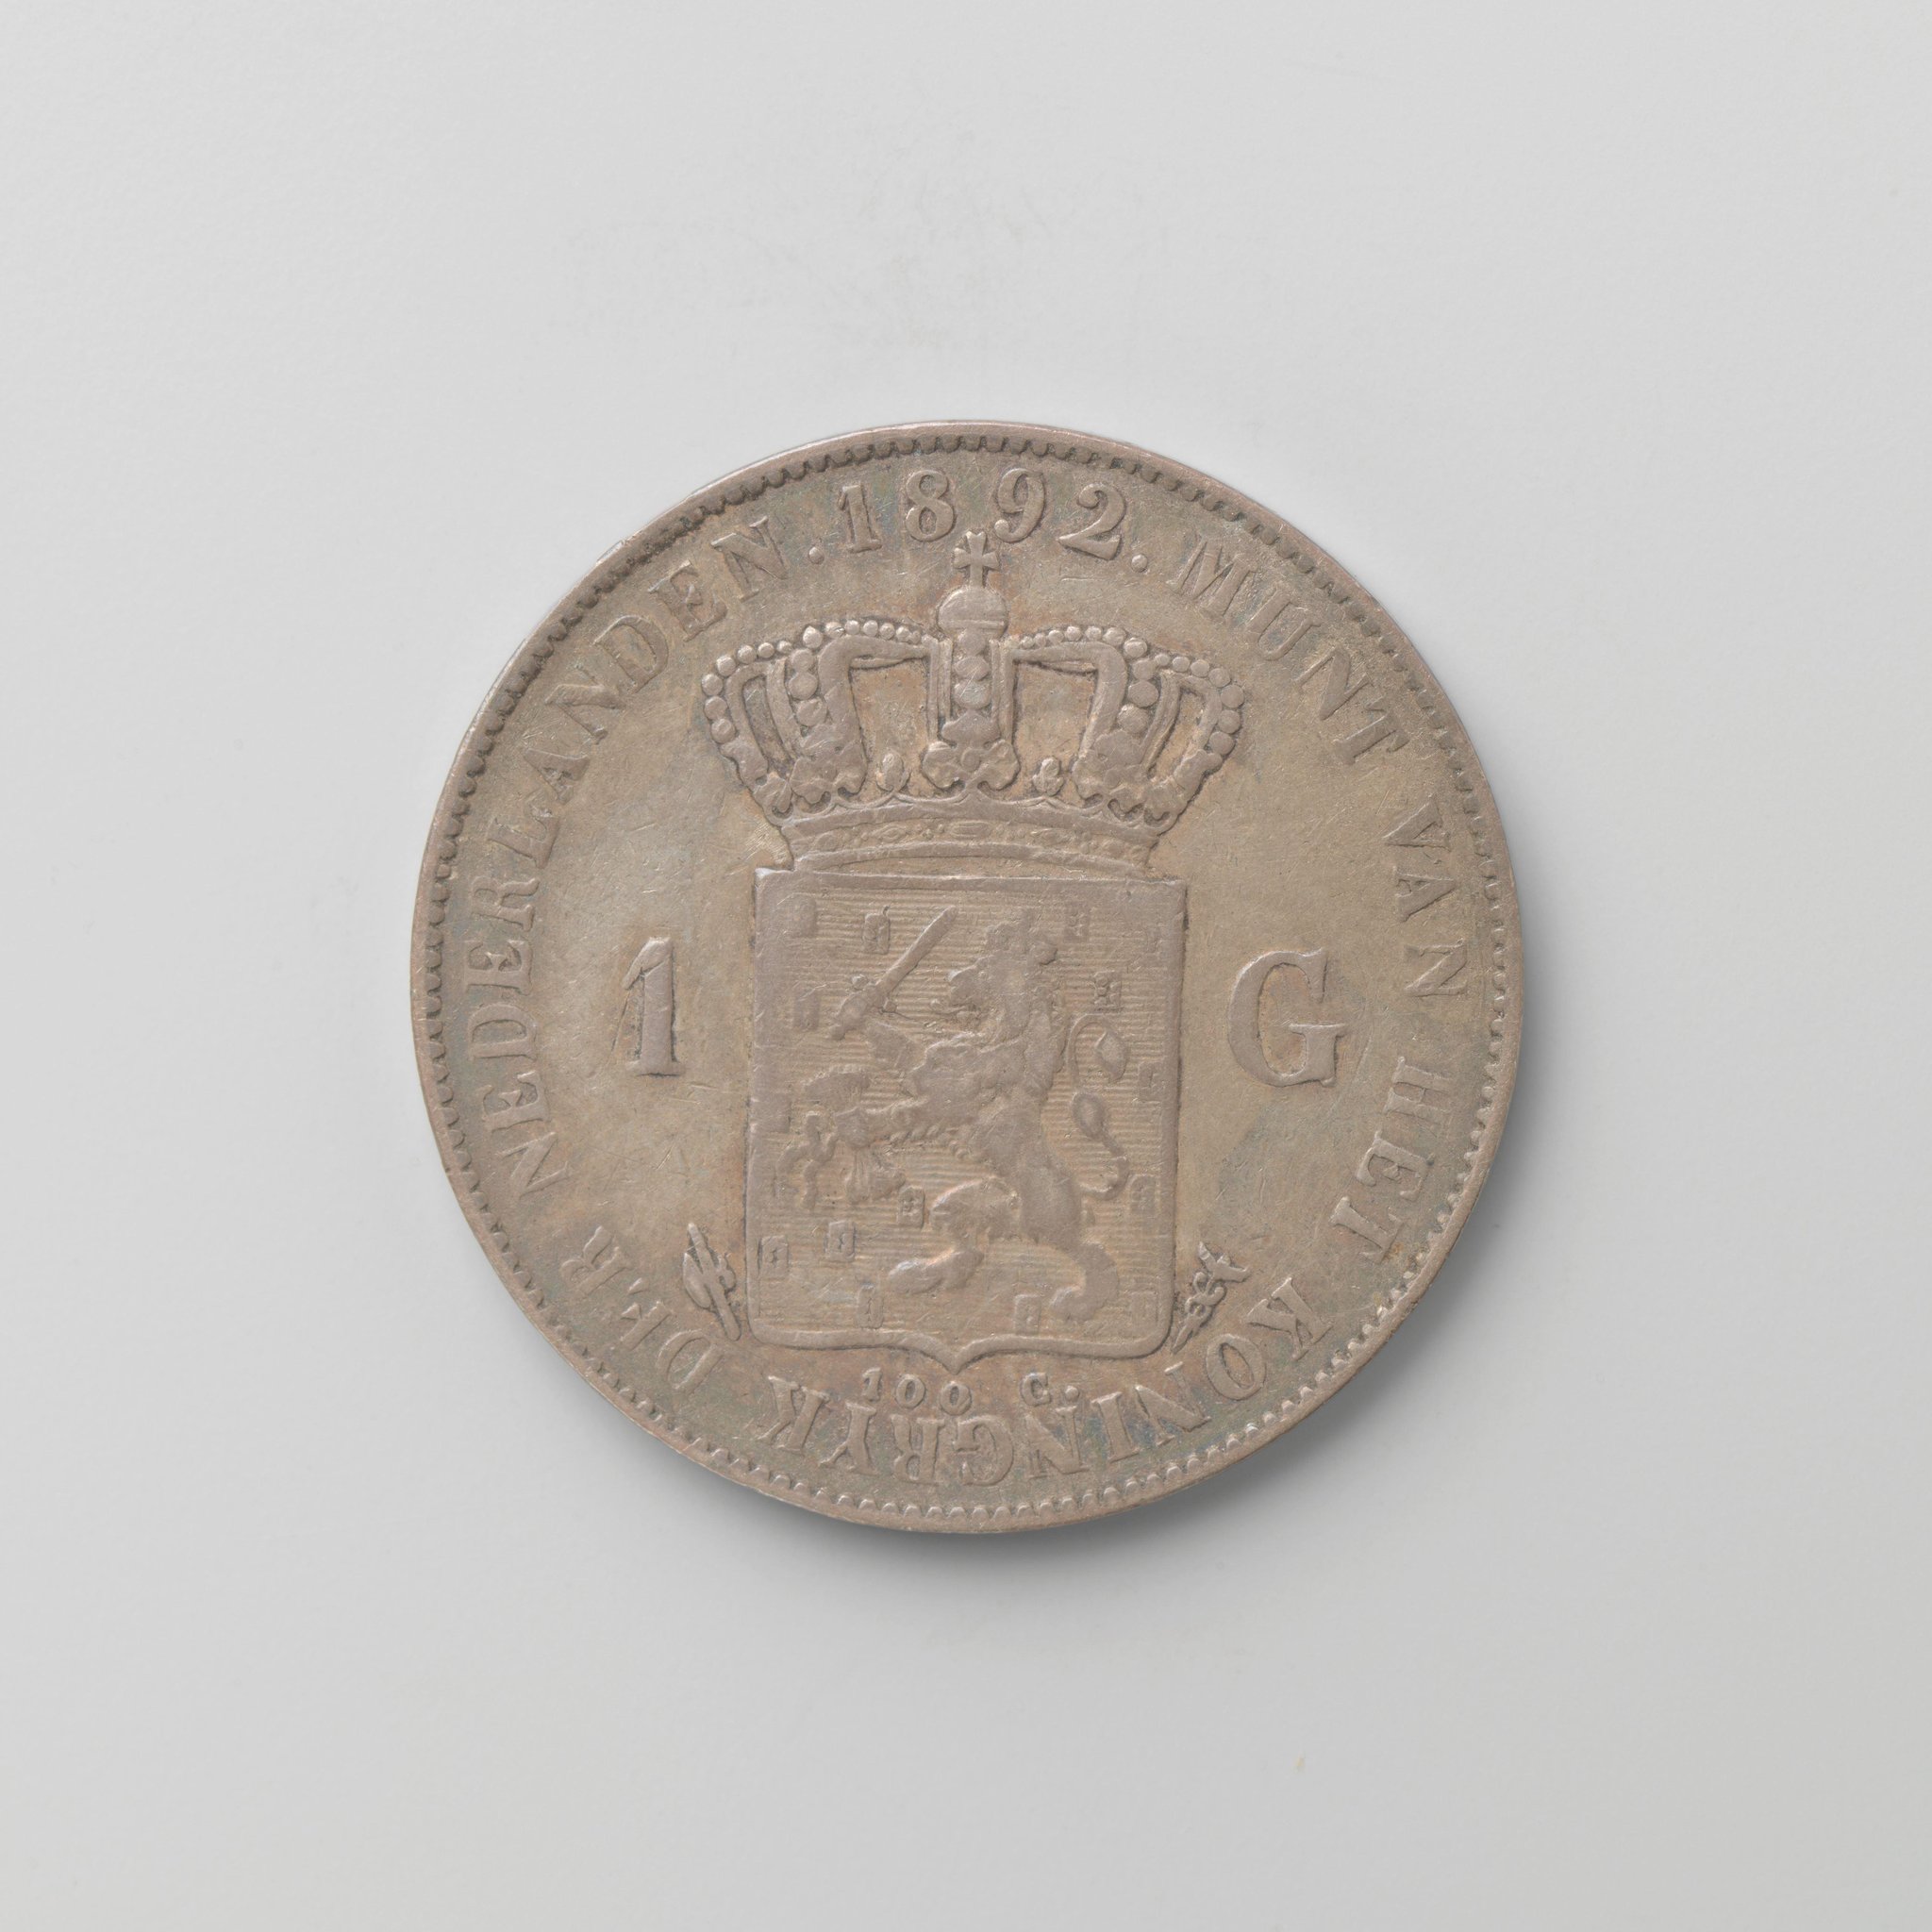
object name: coin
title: Nederlandse gulden,1892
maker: wilhelmina of the netherlands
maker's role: print maker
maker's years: 1880-1962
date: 1892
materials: silver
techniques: striking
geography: utrecht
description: Zilveren munt. Voorzijde: jeugdig borstbeeld naar links. Keerzijde: tussen waarde-aanduiding 1 G gekroond rijkswapenschild. Jaartal bovenaan in omschrift. Randschrift.